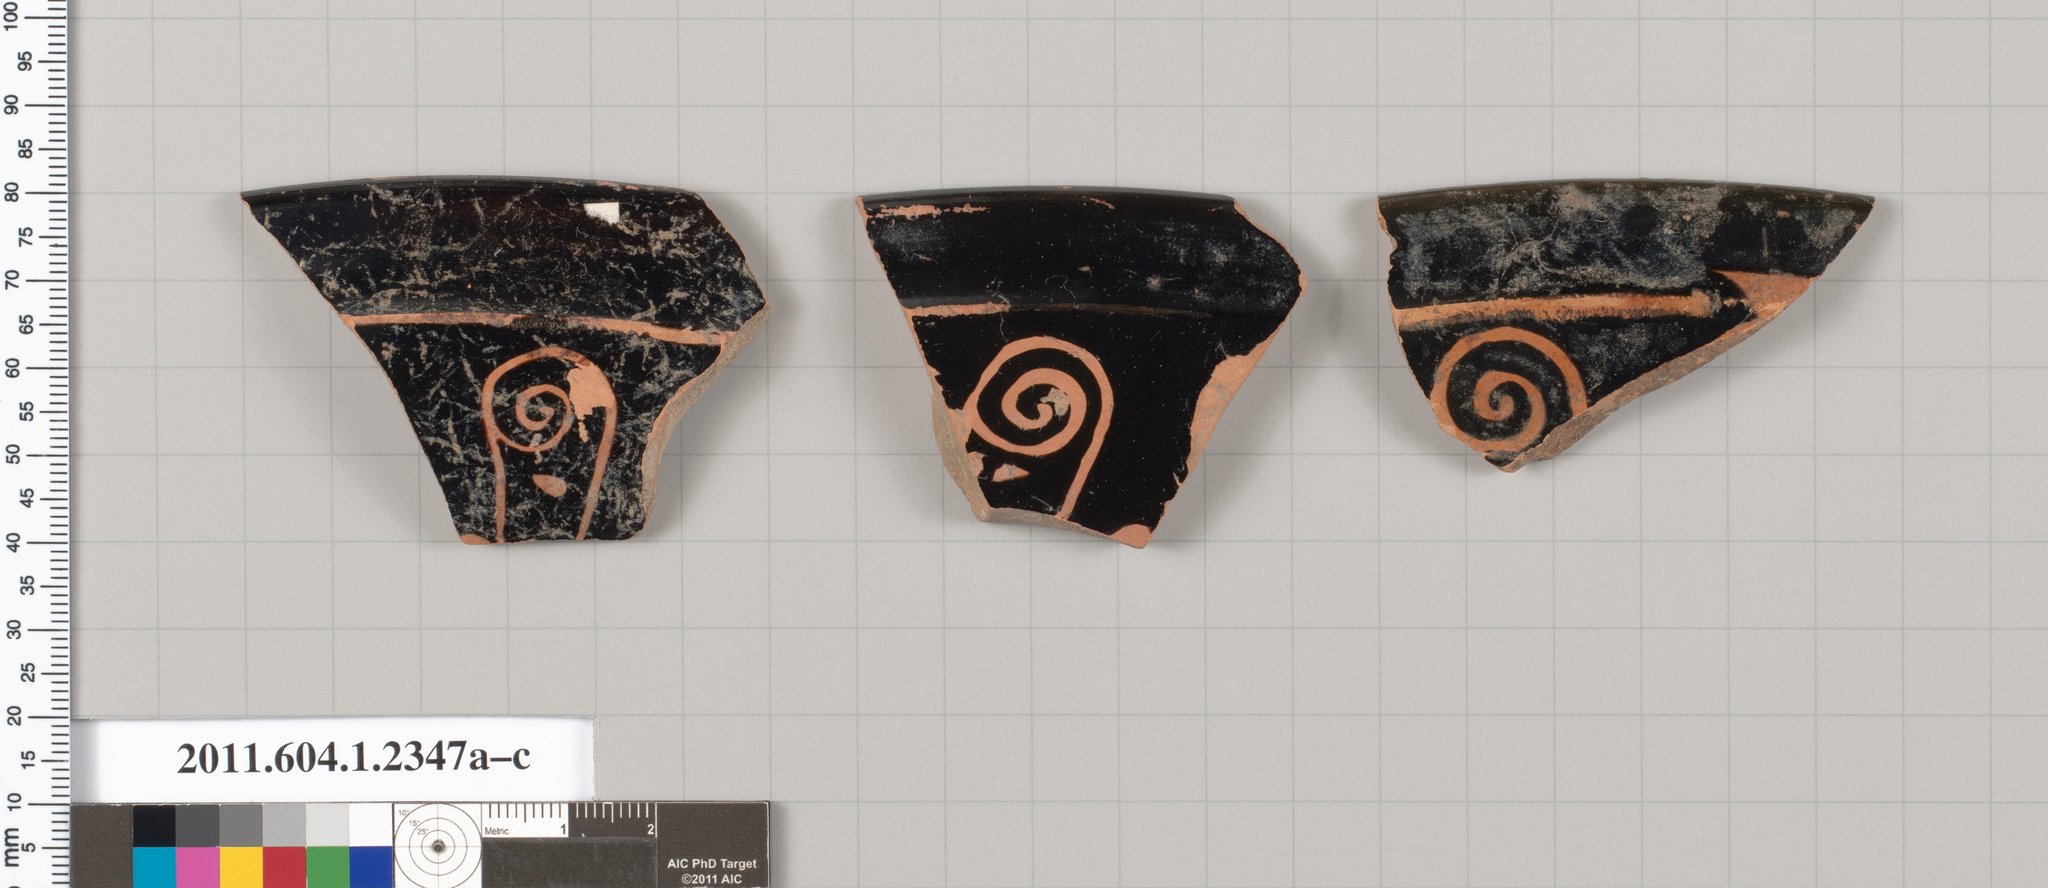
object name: kylix fragment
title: Terracotta rim fragments of kylikes (drinking cups)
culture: greek, attic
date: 475-451 BCE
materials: terracotta